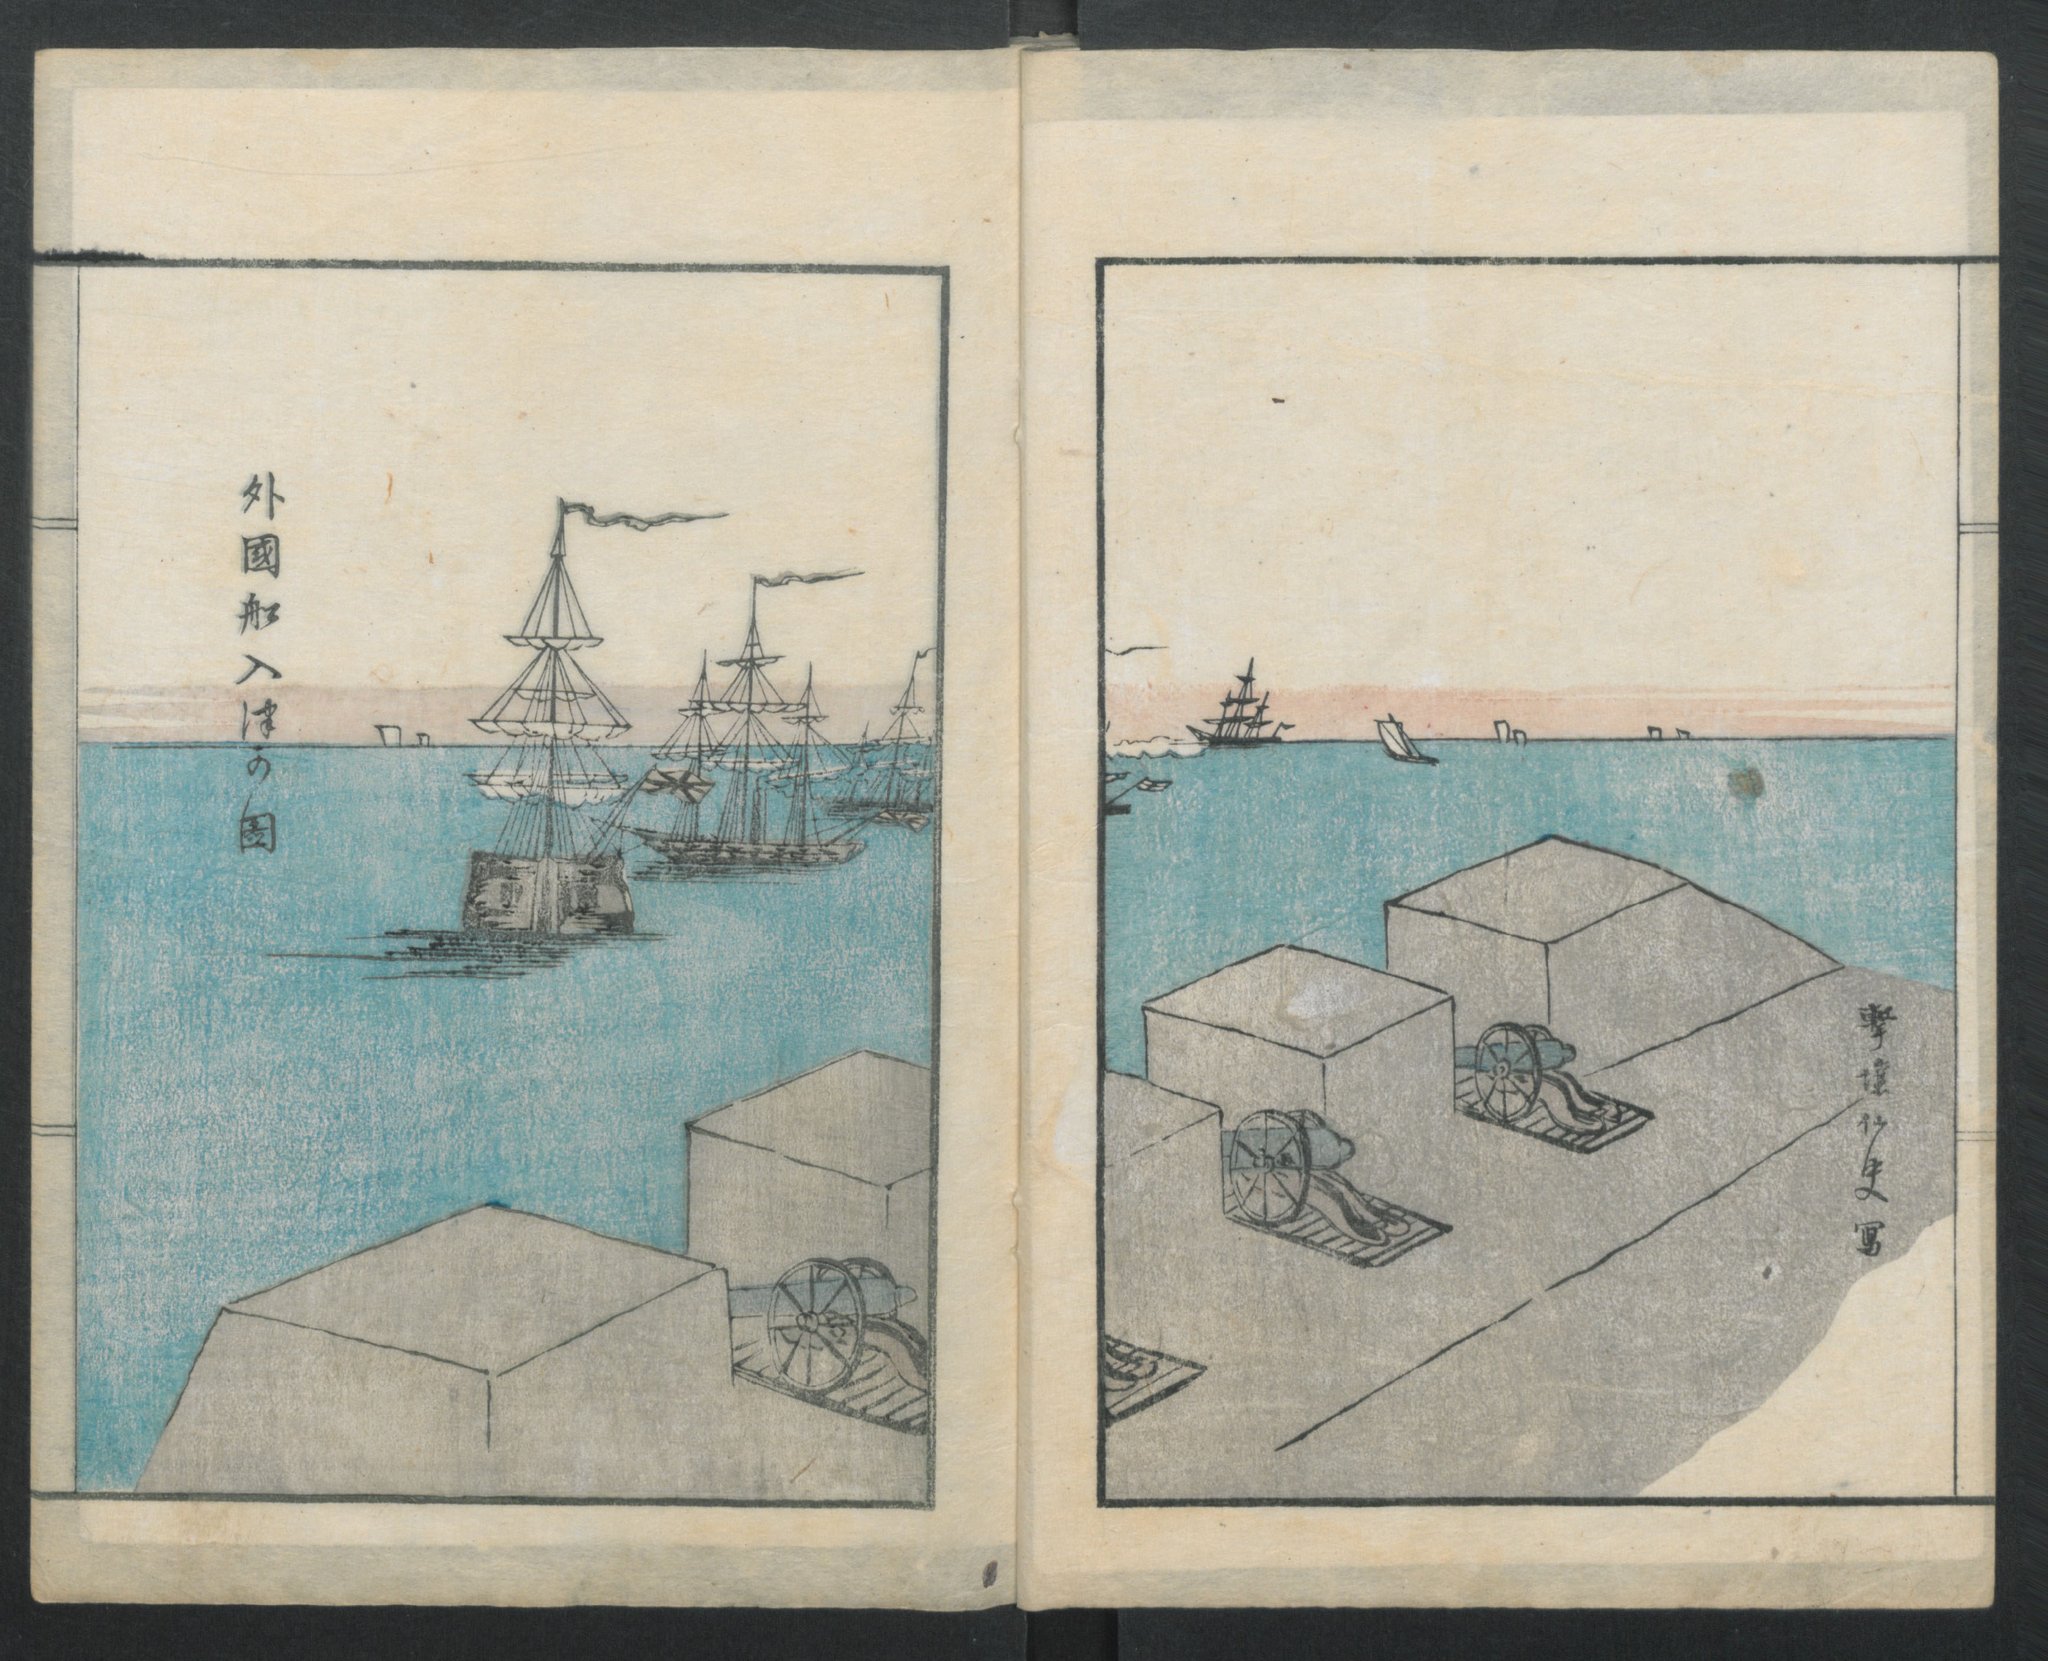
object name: illustrated book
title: Diary of Yokohama (Yokohama hanjōki) 横濱繁昌記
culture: japanese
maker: kinkei rōjin, 錦渓老人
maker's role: artist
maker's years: 1832-1870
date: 1615-1868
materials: ink, paper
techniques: woodblock print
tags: ships